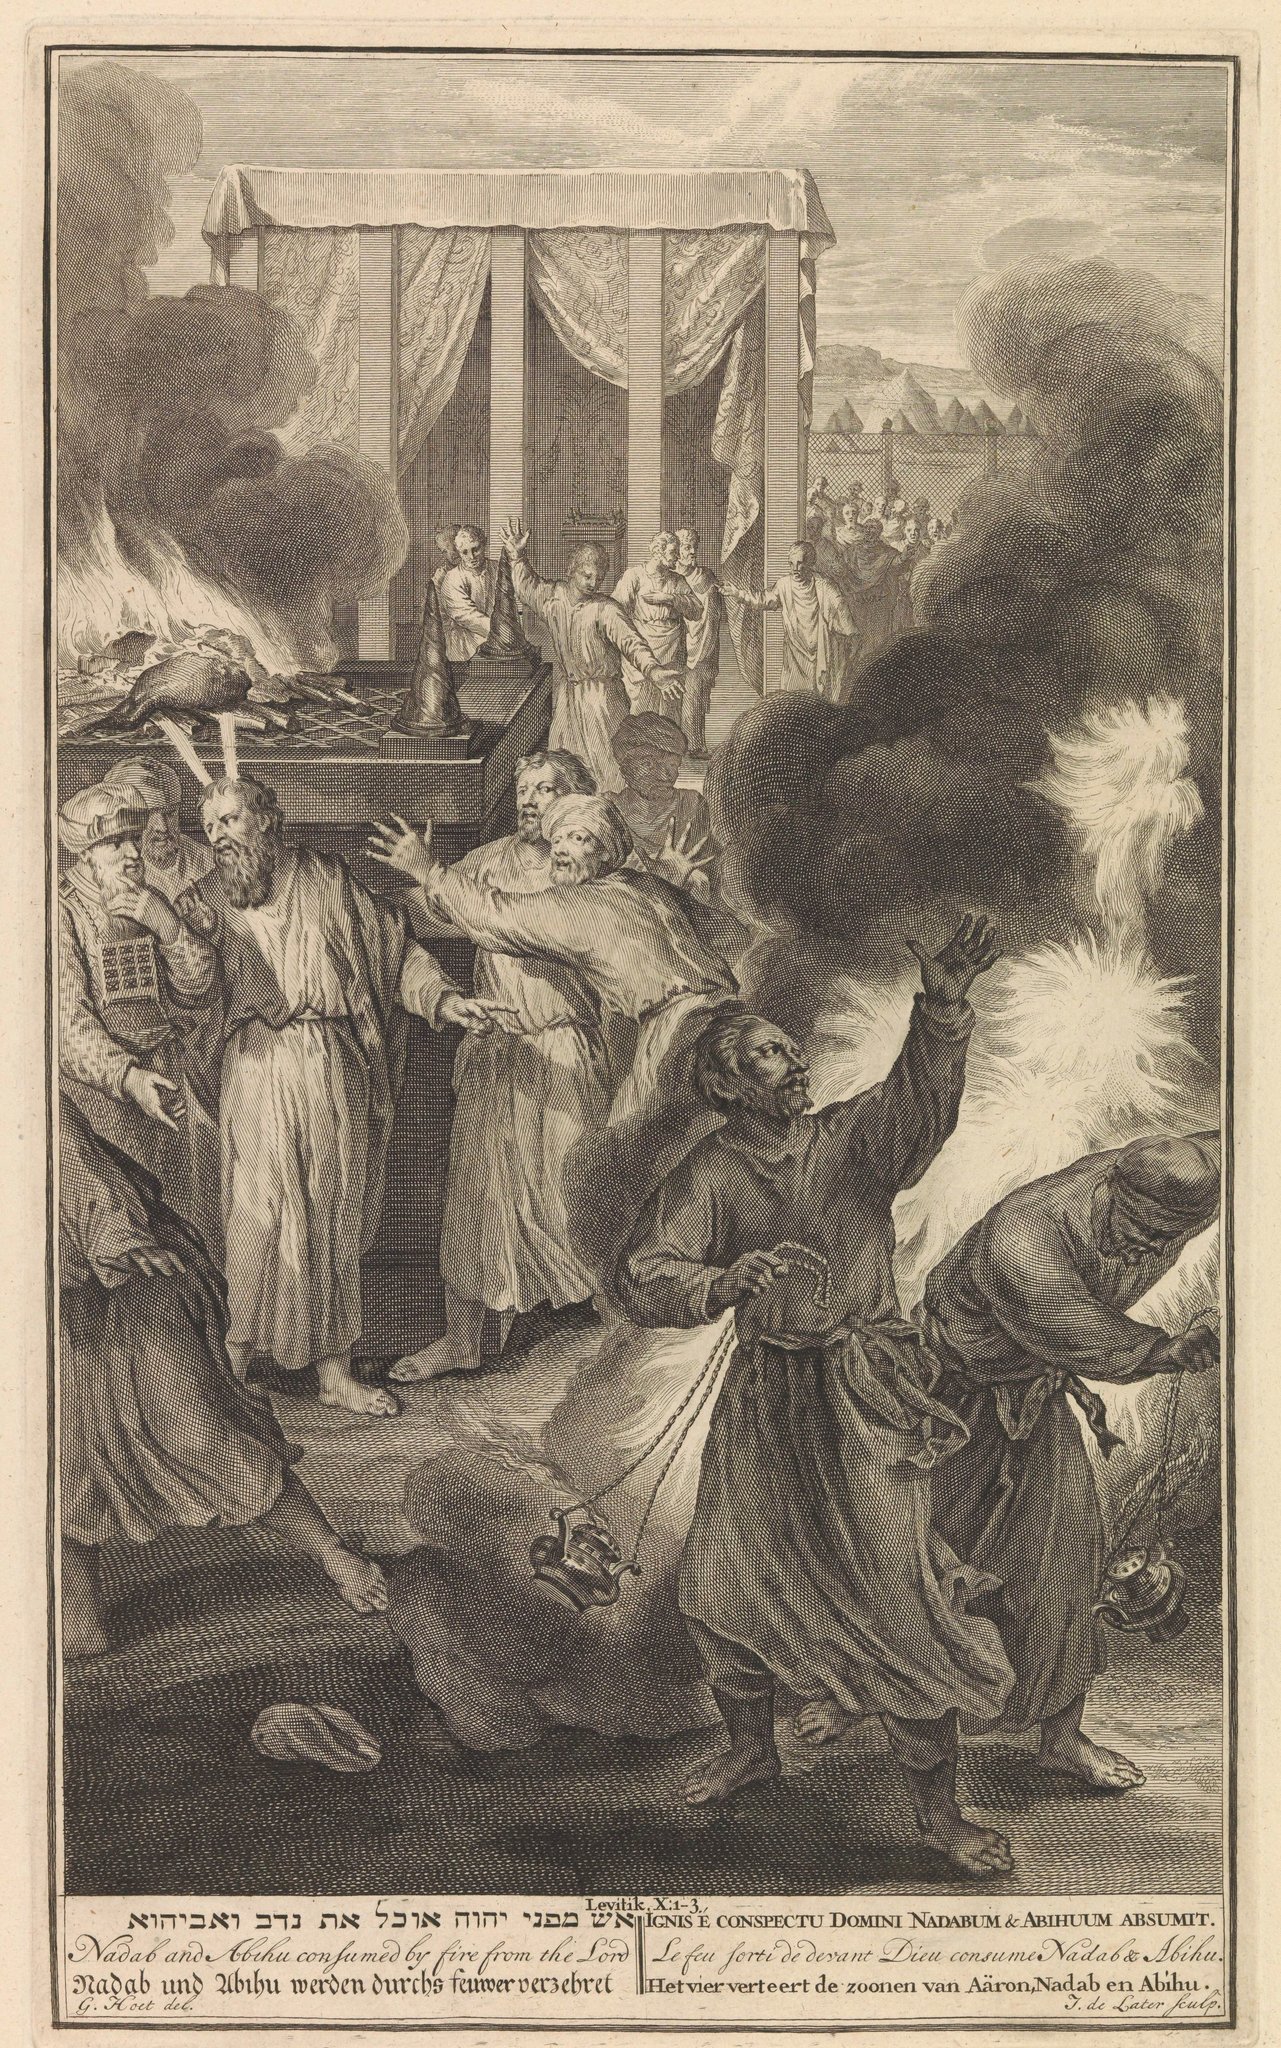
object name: print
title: Nadab en Abihu gedood door vlammen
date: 1728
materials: paper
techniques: engraving, etching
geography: amsterdam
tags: two sons of aaron, nadab and abihu, offer incense in their censers to god, who punishes them for this by sending a fire that kills them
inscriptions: collector's mark: Lugt 2228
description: Prent gemaakt voor: Figures de la Bible. Amsterdam, Bernard Picart, 1720. Prent ook gebruikt in: Taferelen der voornaamste geschiedenissen van het Oude en Nieuwe Testament (...) door de vermaarde kunstenaars Hoet, Houbraken, en Picart getekent (...) en met beschrijvingen uitgebreid. Den Haag: Pieter de Hondt, 1728.